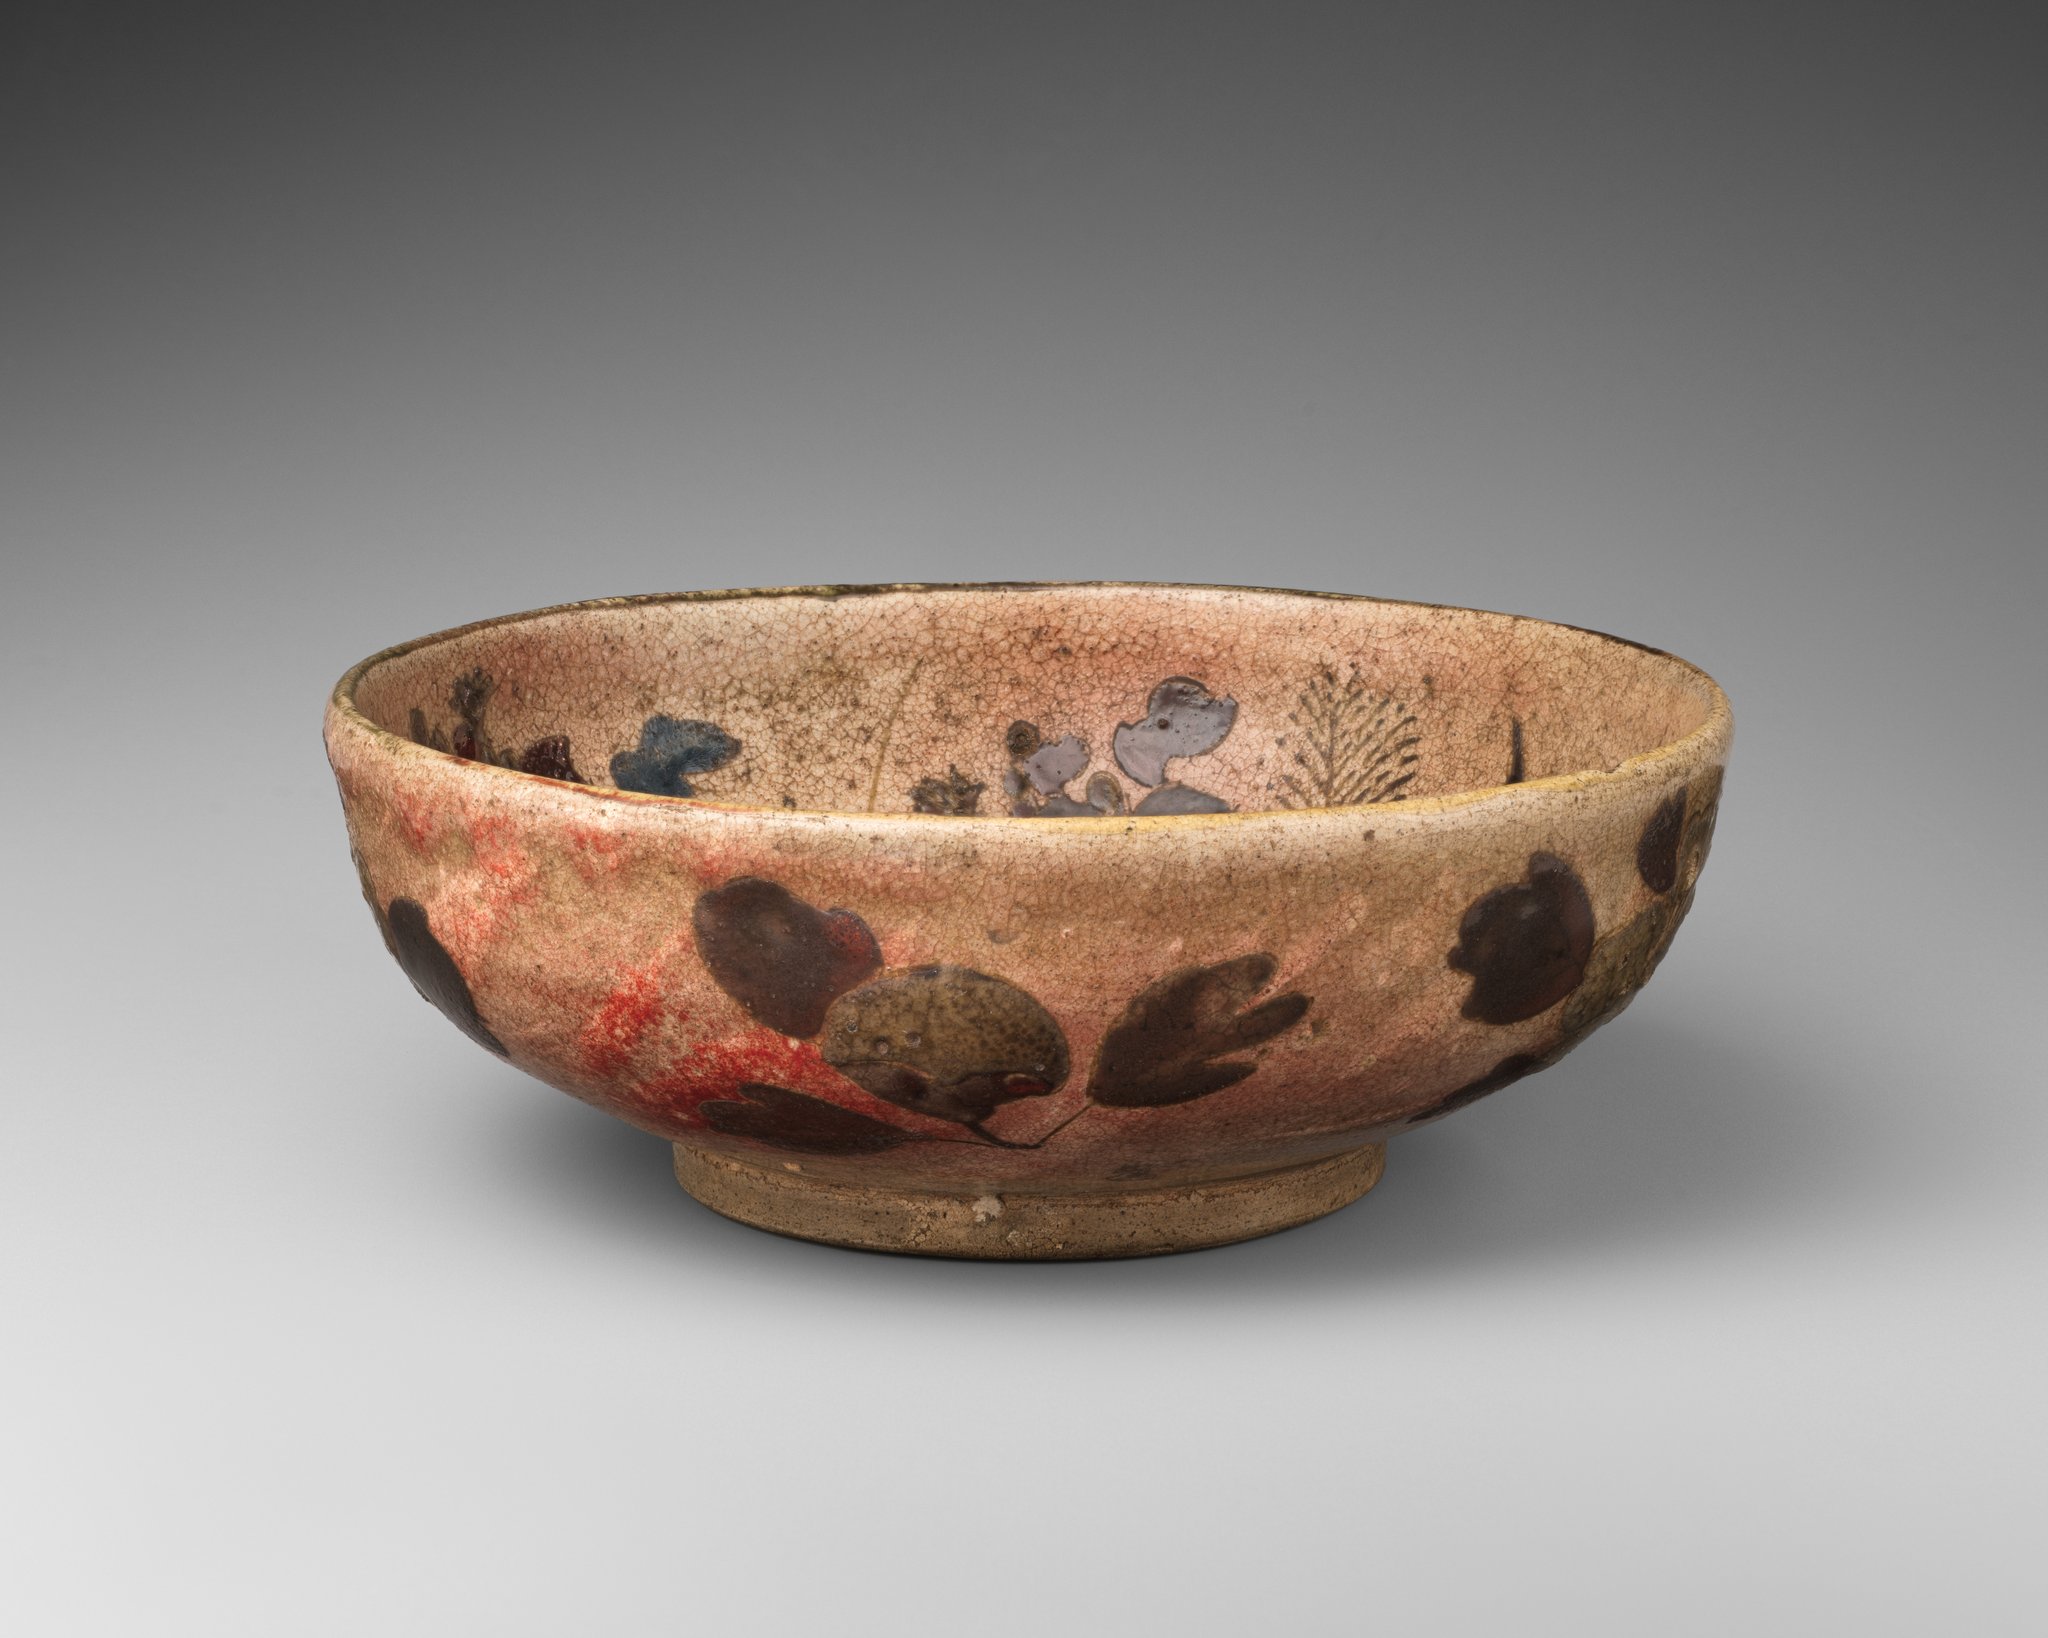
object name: bowl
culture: japanese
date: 1780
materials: pottery